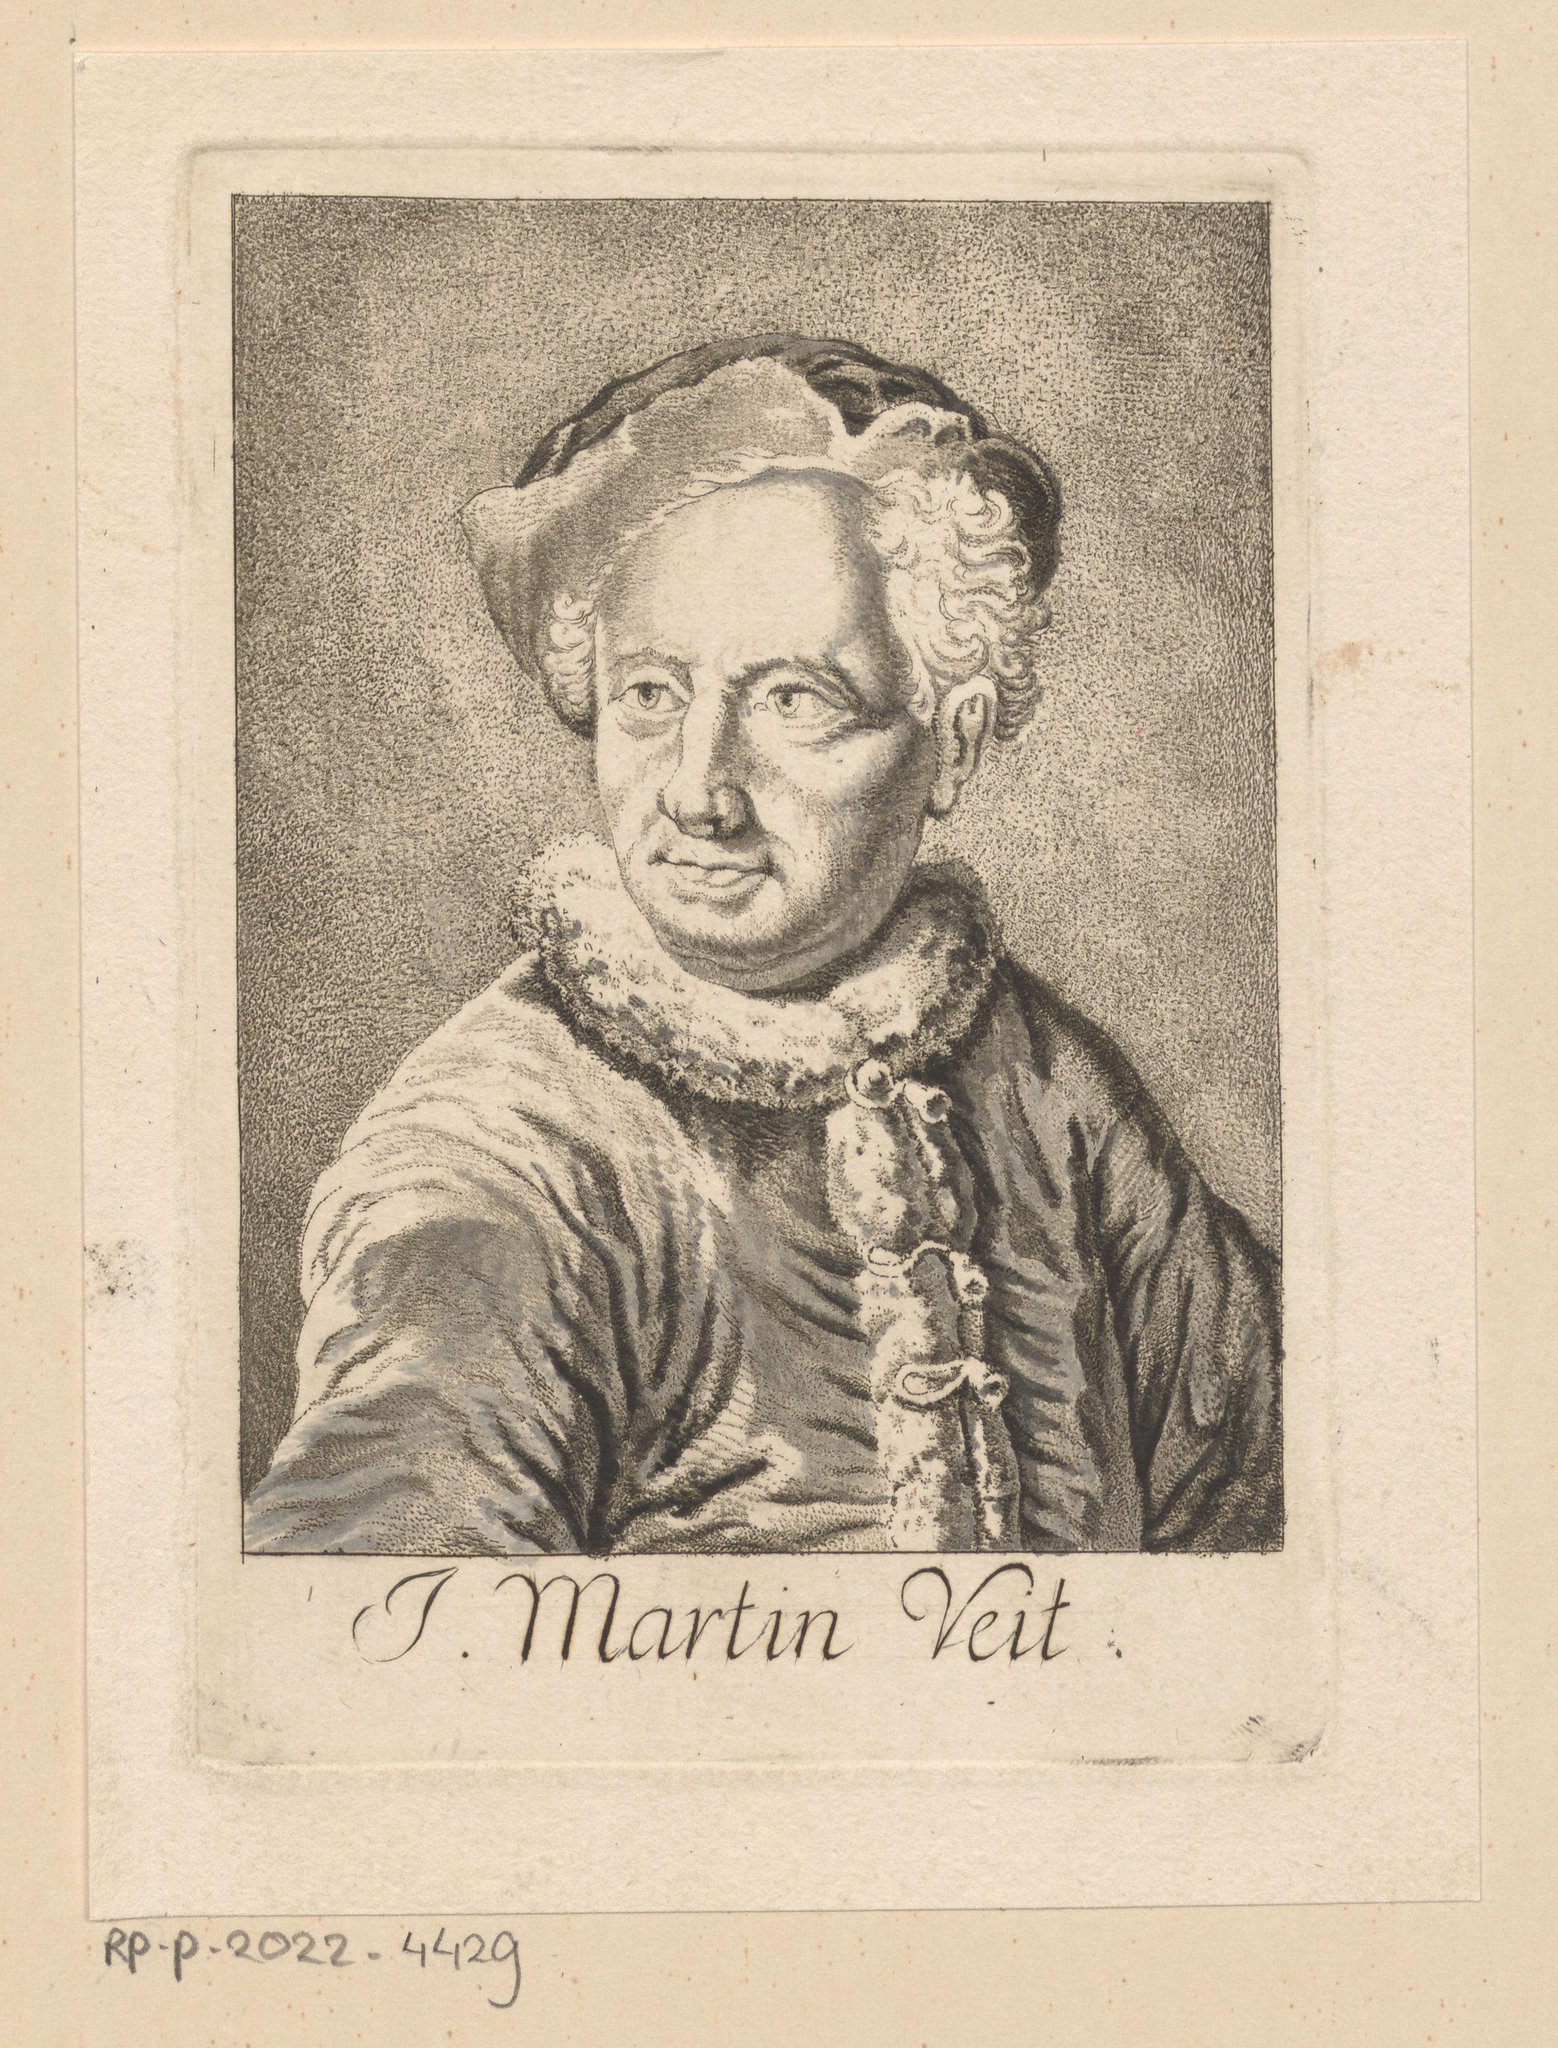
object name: print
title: Portret van Johann Martin Veith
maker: Anonymous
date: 1680-1799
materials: ink, paper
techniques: aquatint, brush, etching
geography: switzerland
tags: painter, draughtsman, artist, johann martin veith, historical persons, portrait, self-portrait of painter